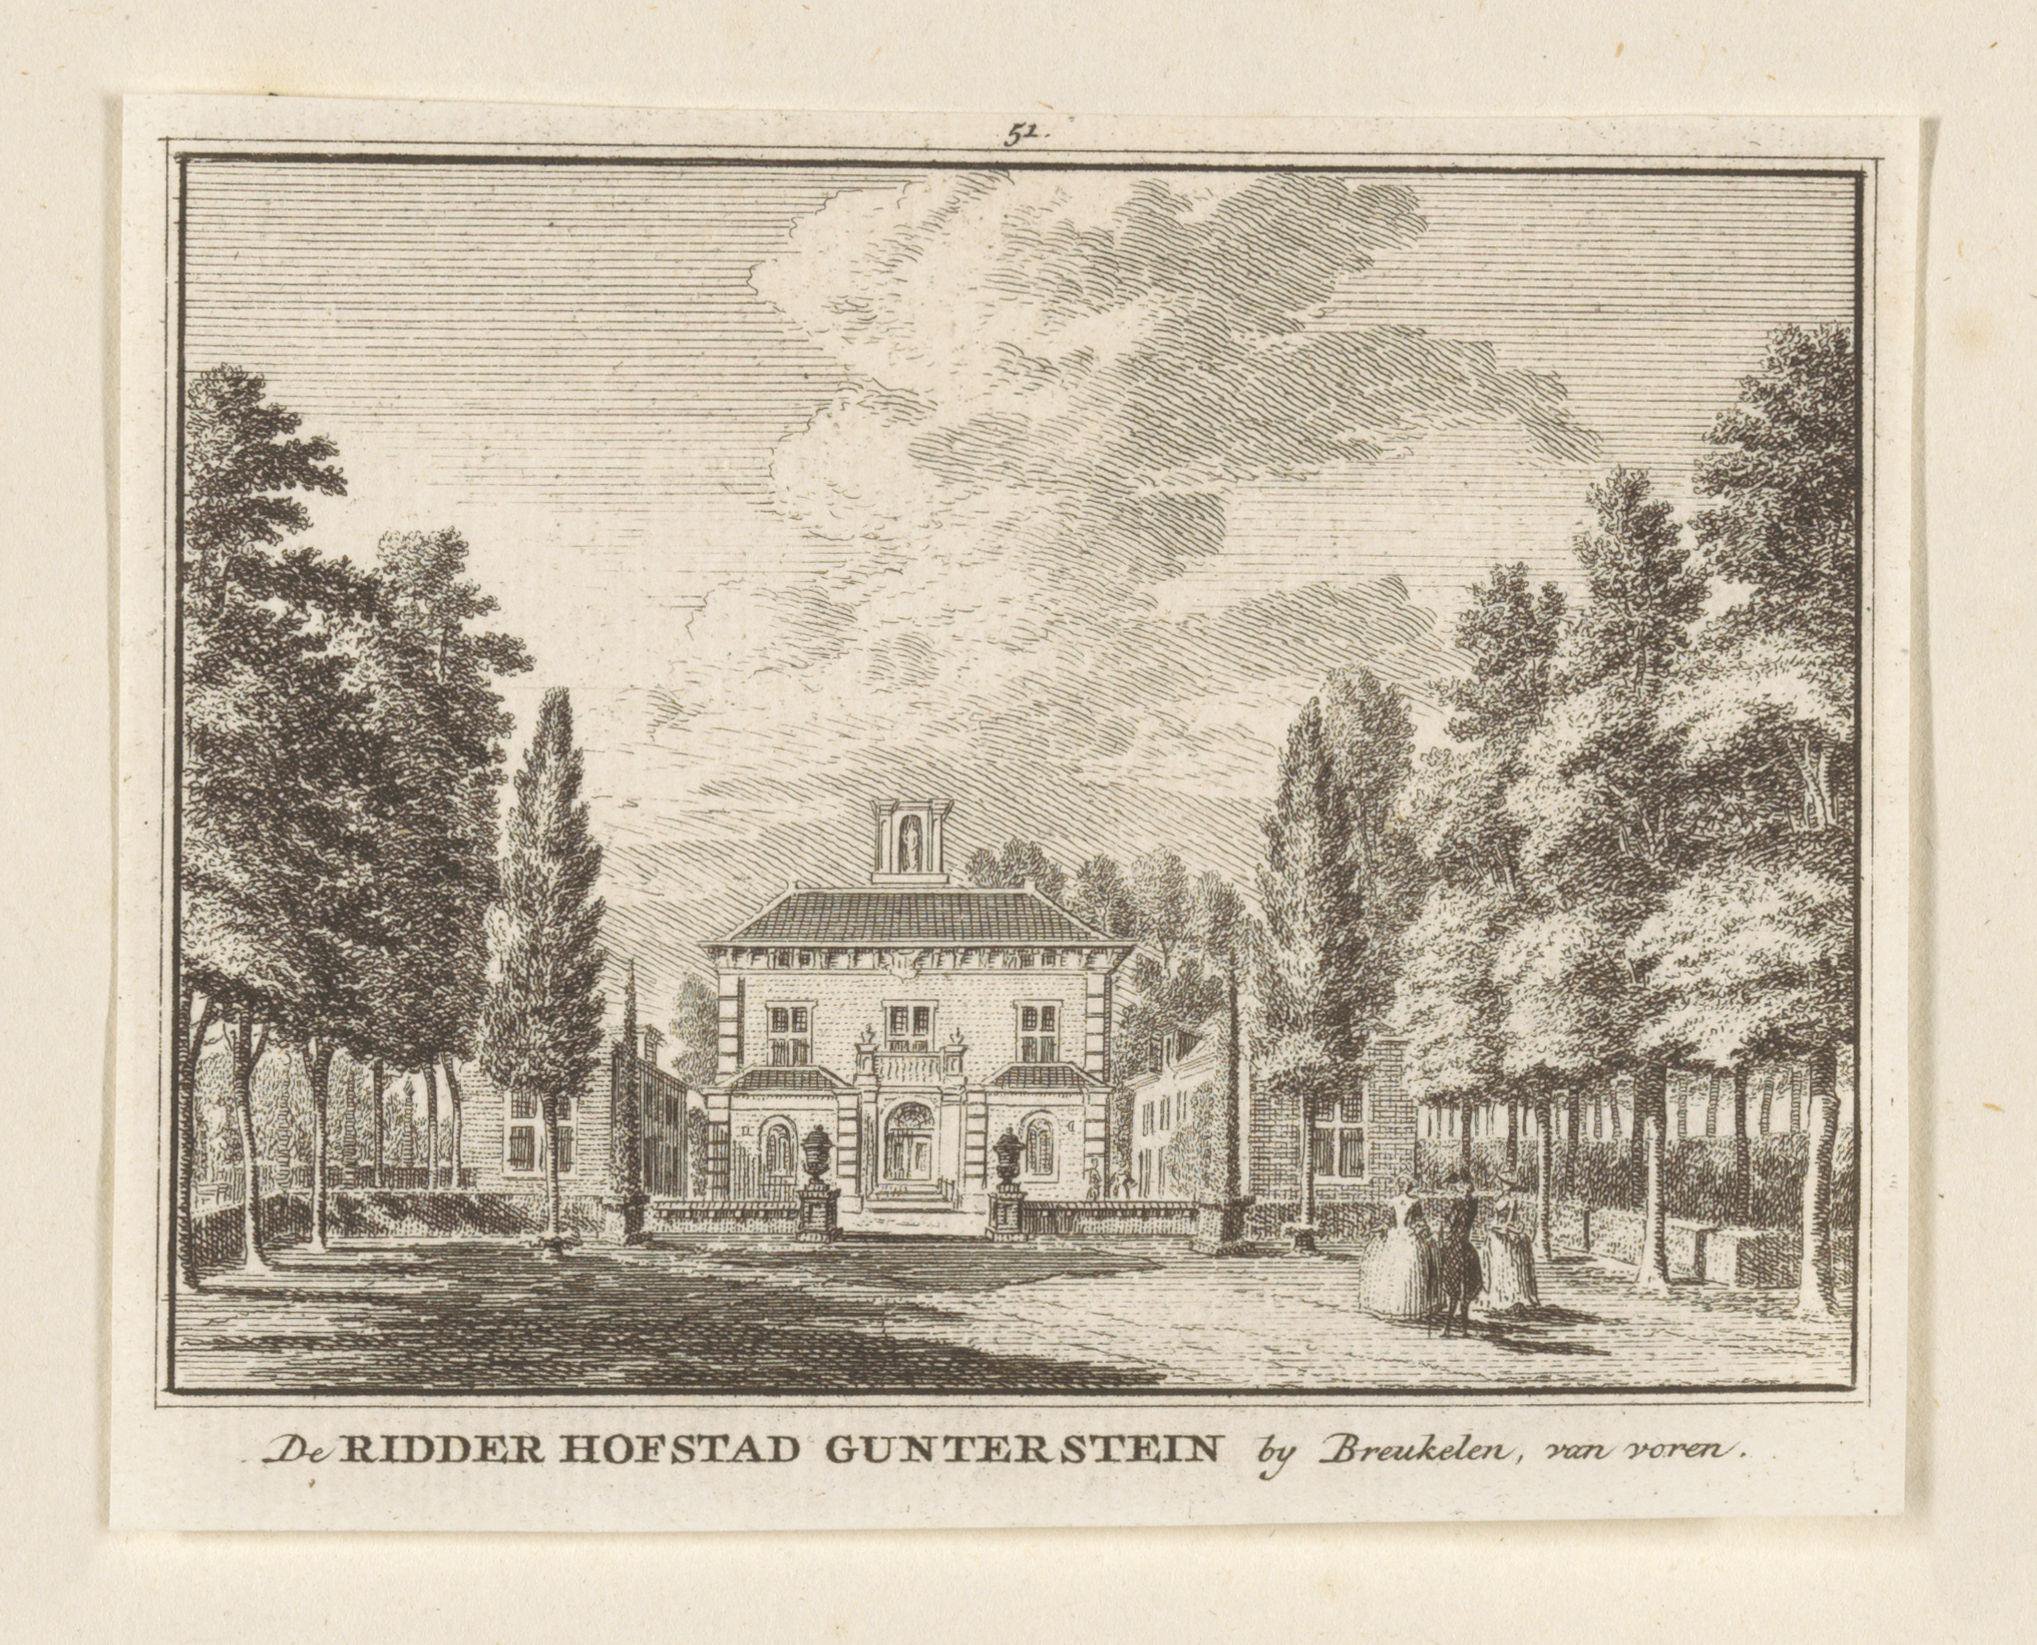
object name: print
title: Gezicht op kasteel Gunterstein te Breukelen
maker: hendrik spilman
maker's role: draughtsman, painter, print maker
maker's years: 1721-1784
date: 1773-1792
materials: paper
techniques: engraving, etching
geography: haarlem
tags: castle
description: Prent ook gebruikt in: Het verheerlykt Nederland of kabinet van hedendaagsche gezigten van steden, dorpen (…). 9 delen. Amsterdam: Isaak Tirion en weduwe Isaak Tirion, 1745-1774, dl. 7, 8 of 9 (weduwe Isaak Tirion, 1773-1774), ill. 51. Of in: Nederlandsche tafereelen; of eene keurige verzameling van negen honderd fraaije gezigten van steden, dorpen, sloten, oudheden (….). 9 delen. Amsterdam: Jan de Groot, 1792, dl. 7, 8 of 9, ill. 51. Uit welke druk het huidige exemplaar precies komt is niet na te gaan.